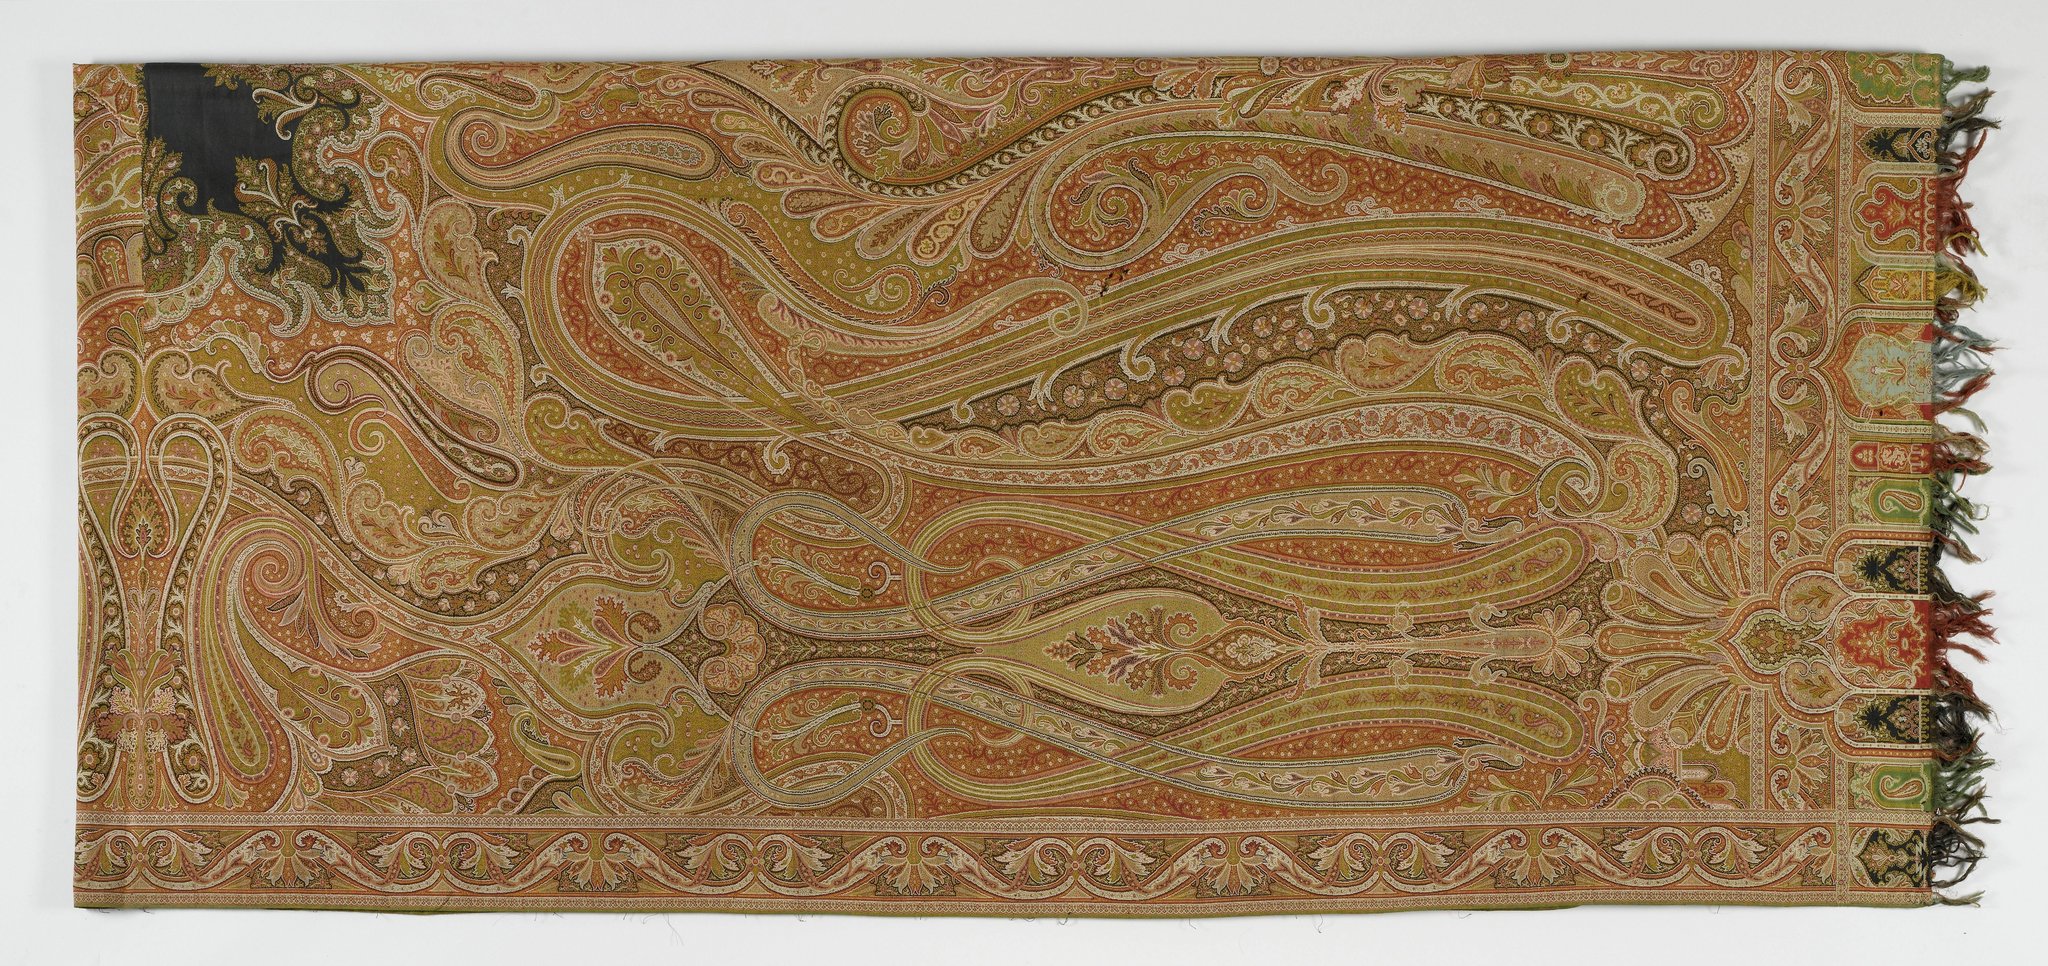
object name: kashmir shawl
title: Rechthoekige kasjmiersjaal met een gehalveerde zwarte spiegel met veelkleurige langgerekte bota- en waaierpalmetmotieven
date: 1850-1870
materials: wool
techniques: weave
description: Rechthoekige palmensjaal van wol, met een geweven patroon waarop een gehalveerde zwarte spiegel en veelkleurige langgerekte, ineengestrengelde veer-, of boteh- en waaierpalmetmotieven. Het middenpatroon is symmetrisch t.o.v. een lange staande as en een korte dwars-as. Een centrum van een halve zwarte spiegel en half, veelkleurige bota-uitstralingen. Aan beide einden staat een zeer lange middenpalmet, met zwart omlijnd en met een waaierkroon van kleine Kasmir veer- of botamotieven. Hij steunt op een langgerekte tweede waaierpalmet, die tussen twee slanke bota's staat. Links en rechts hiervan weer langgerekte en door elkaar gestrengelde bota's, waarvan de ronde voluut op gehouden is. Terzijde kortere dito's. In de staande rand stuiten de toegwende S-motieven in liggende formatie tegen elkaar aan. Hij is gevat in smalle witte lijsten. De liggende rand is samengesteld van ongelijkvormige poorten, symmetrisch in kleuren geschikt t.o.v. de staande midden-as, in groen, zwart, rood, okergeel en turquoise met veelkleurige en veelvuldige omtrekken, o.a. in wit. Twee buitenste poorten zijn groter, met drie bogen. Zij worden bekroond door één waaierpalmet die uit de rand steekt over het middenpatroon. De techniek bestaat uit een partieel gekleurde wollen ketting, met een wollen inslag, die a/d achterzijde niet is afgeknipt en flottant overloopt.